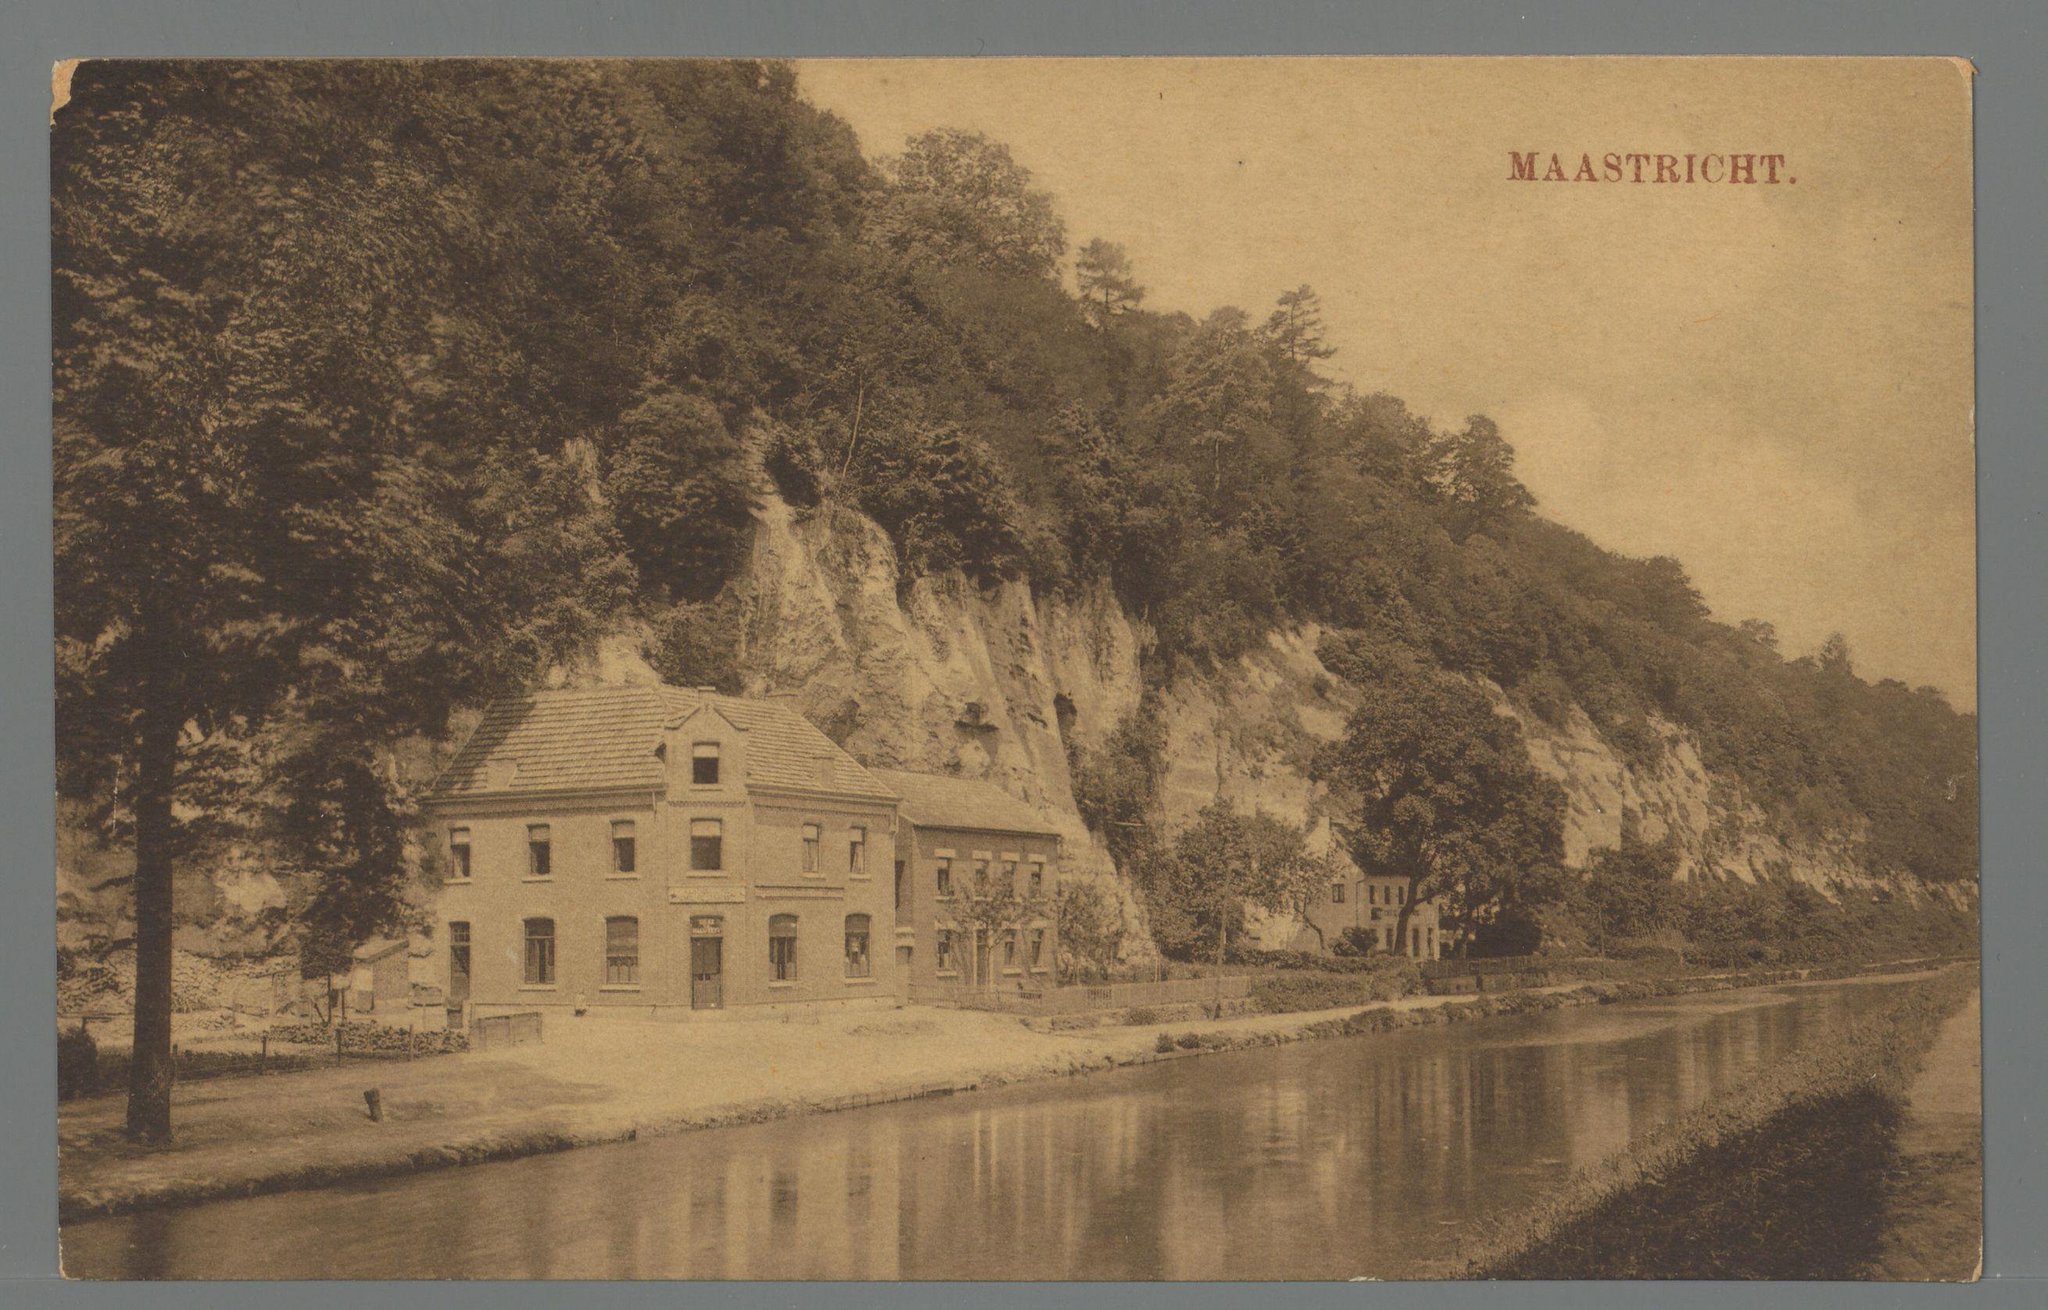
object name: ansichtkaart, prentbriefkaart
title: Maastricht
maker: Anonymous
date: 1905-1927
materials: cardboard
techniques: photograph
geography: maastricht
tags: canal, maastricht